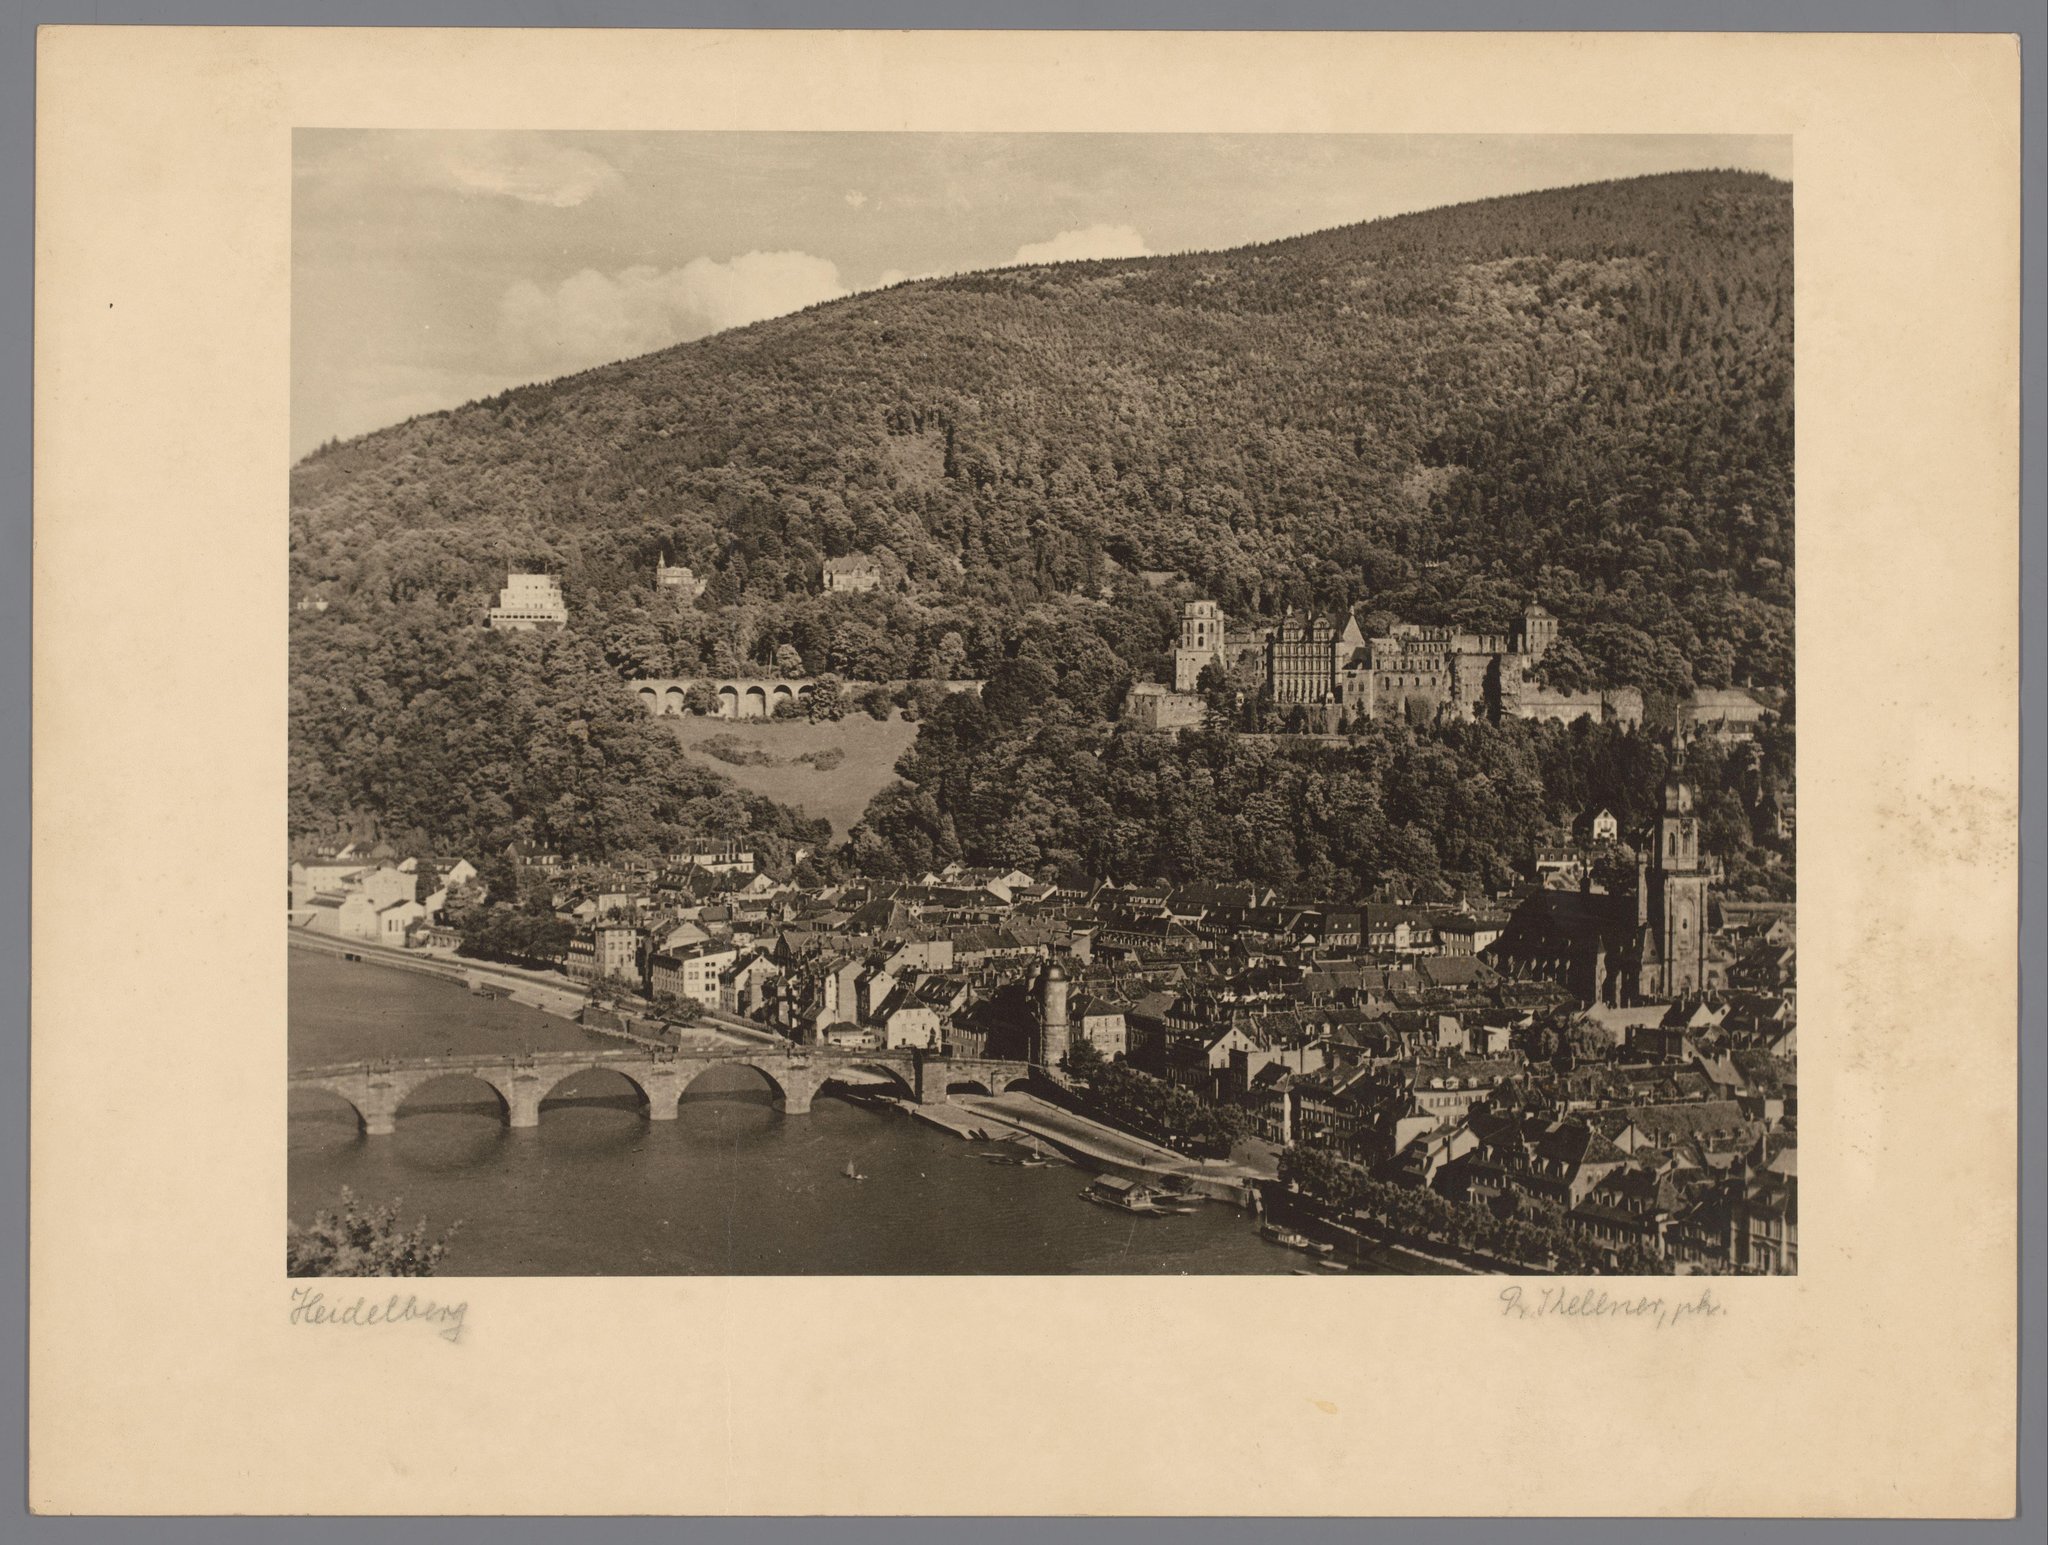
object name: stereograph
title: Gezicht op de Notre-Dame in Parijs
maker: Anonymous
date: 1850-1880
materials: cardboard, photographic support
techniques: albumen print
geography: paris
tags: scaffold (~ building activities), church (exterior)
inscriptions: inscription: ‘N. Dame’